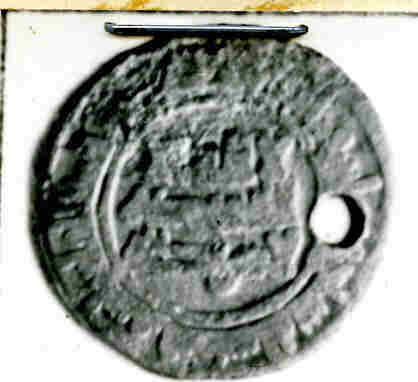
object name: coin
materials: copper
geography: uzbekistan